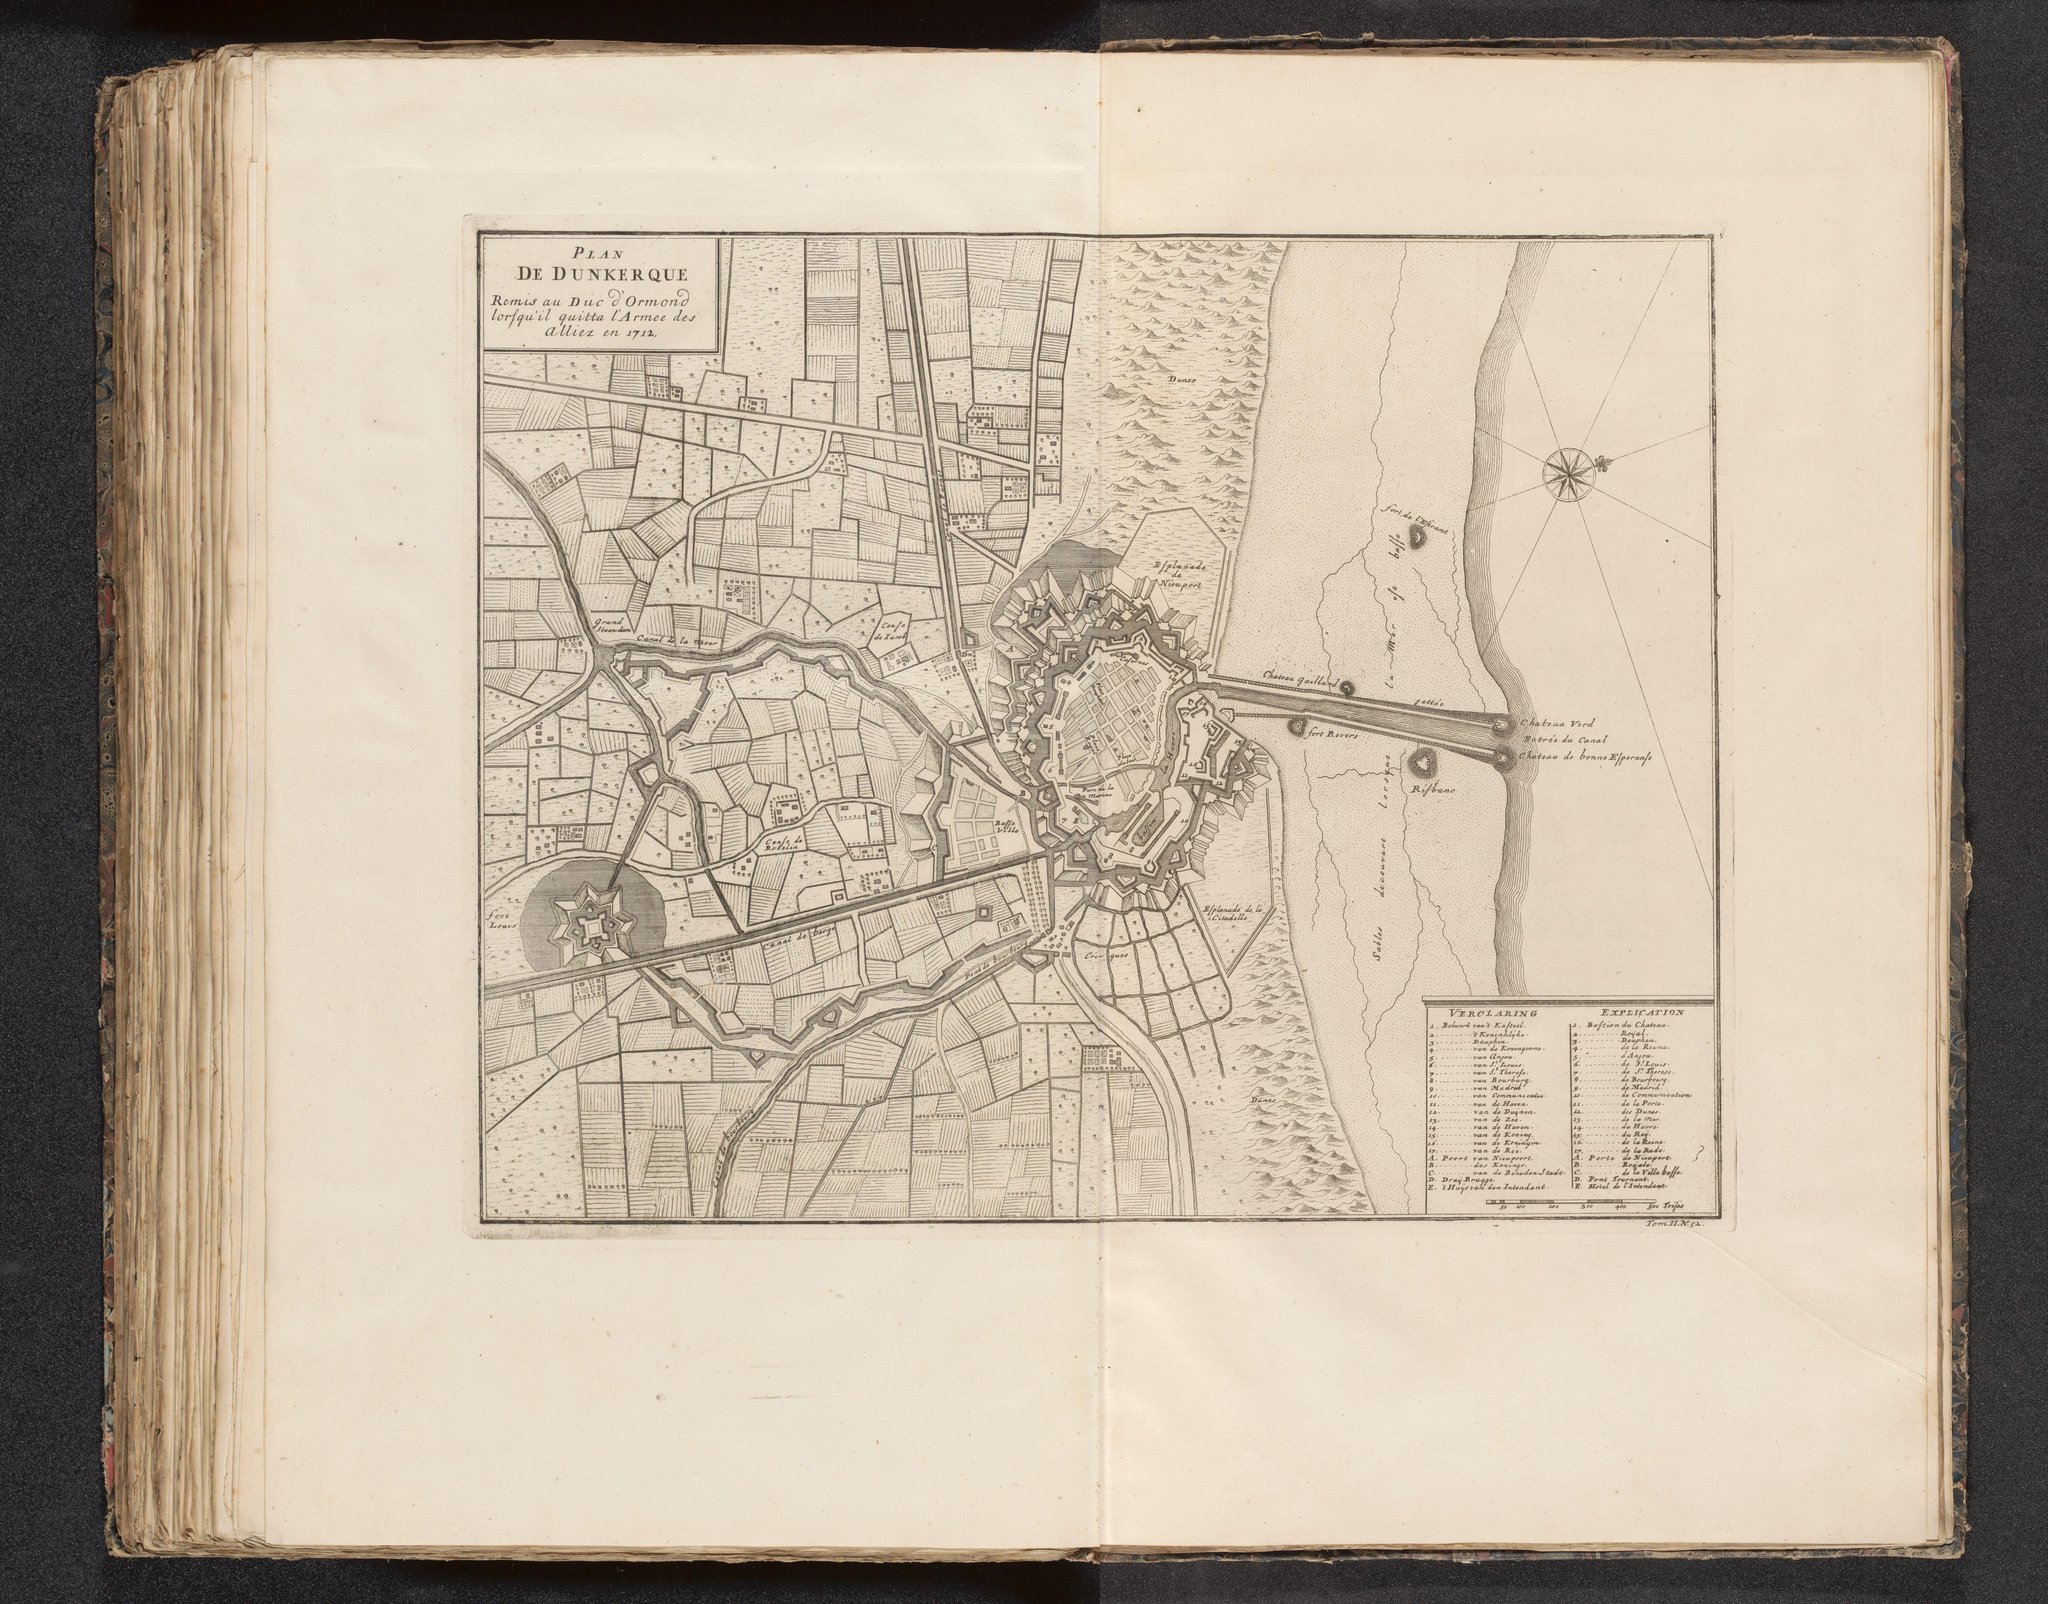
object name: map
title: Plan de Dunkerque Remis au Duc d'Ormond lorsqu'il quitta l'Armée des Alliez en 1712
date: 1712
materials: paper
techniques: etching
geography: northern netherlands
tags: maps of cities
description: Plattegrond van Duinkerke, in juli 1712 als onderpand door de Fransen aan de hertog van Ormond overgedragen. Genummerd rechtsonder: Tom. II. No. 52. Illustratie in het tweede deel van : [Jean] du Mont, Oorlogskundige beschryving van de veldslagen en belegeringen, der drie ... wydvermaarde krygsoversten... den Prins Eugenius van Savoye, den ... Hertog van Marlborough, en den Prins van Oranje en Nassau-Vriesland, in de editie van 1729. Dit tweede deel is hoofdzakelijk gewijd aan de daden van de hertog van Marlborough en prins Johan Willem Friso.